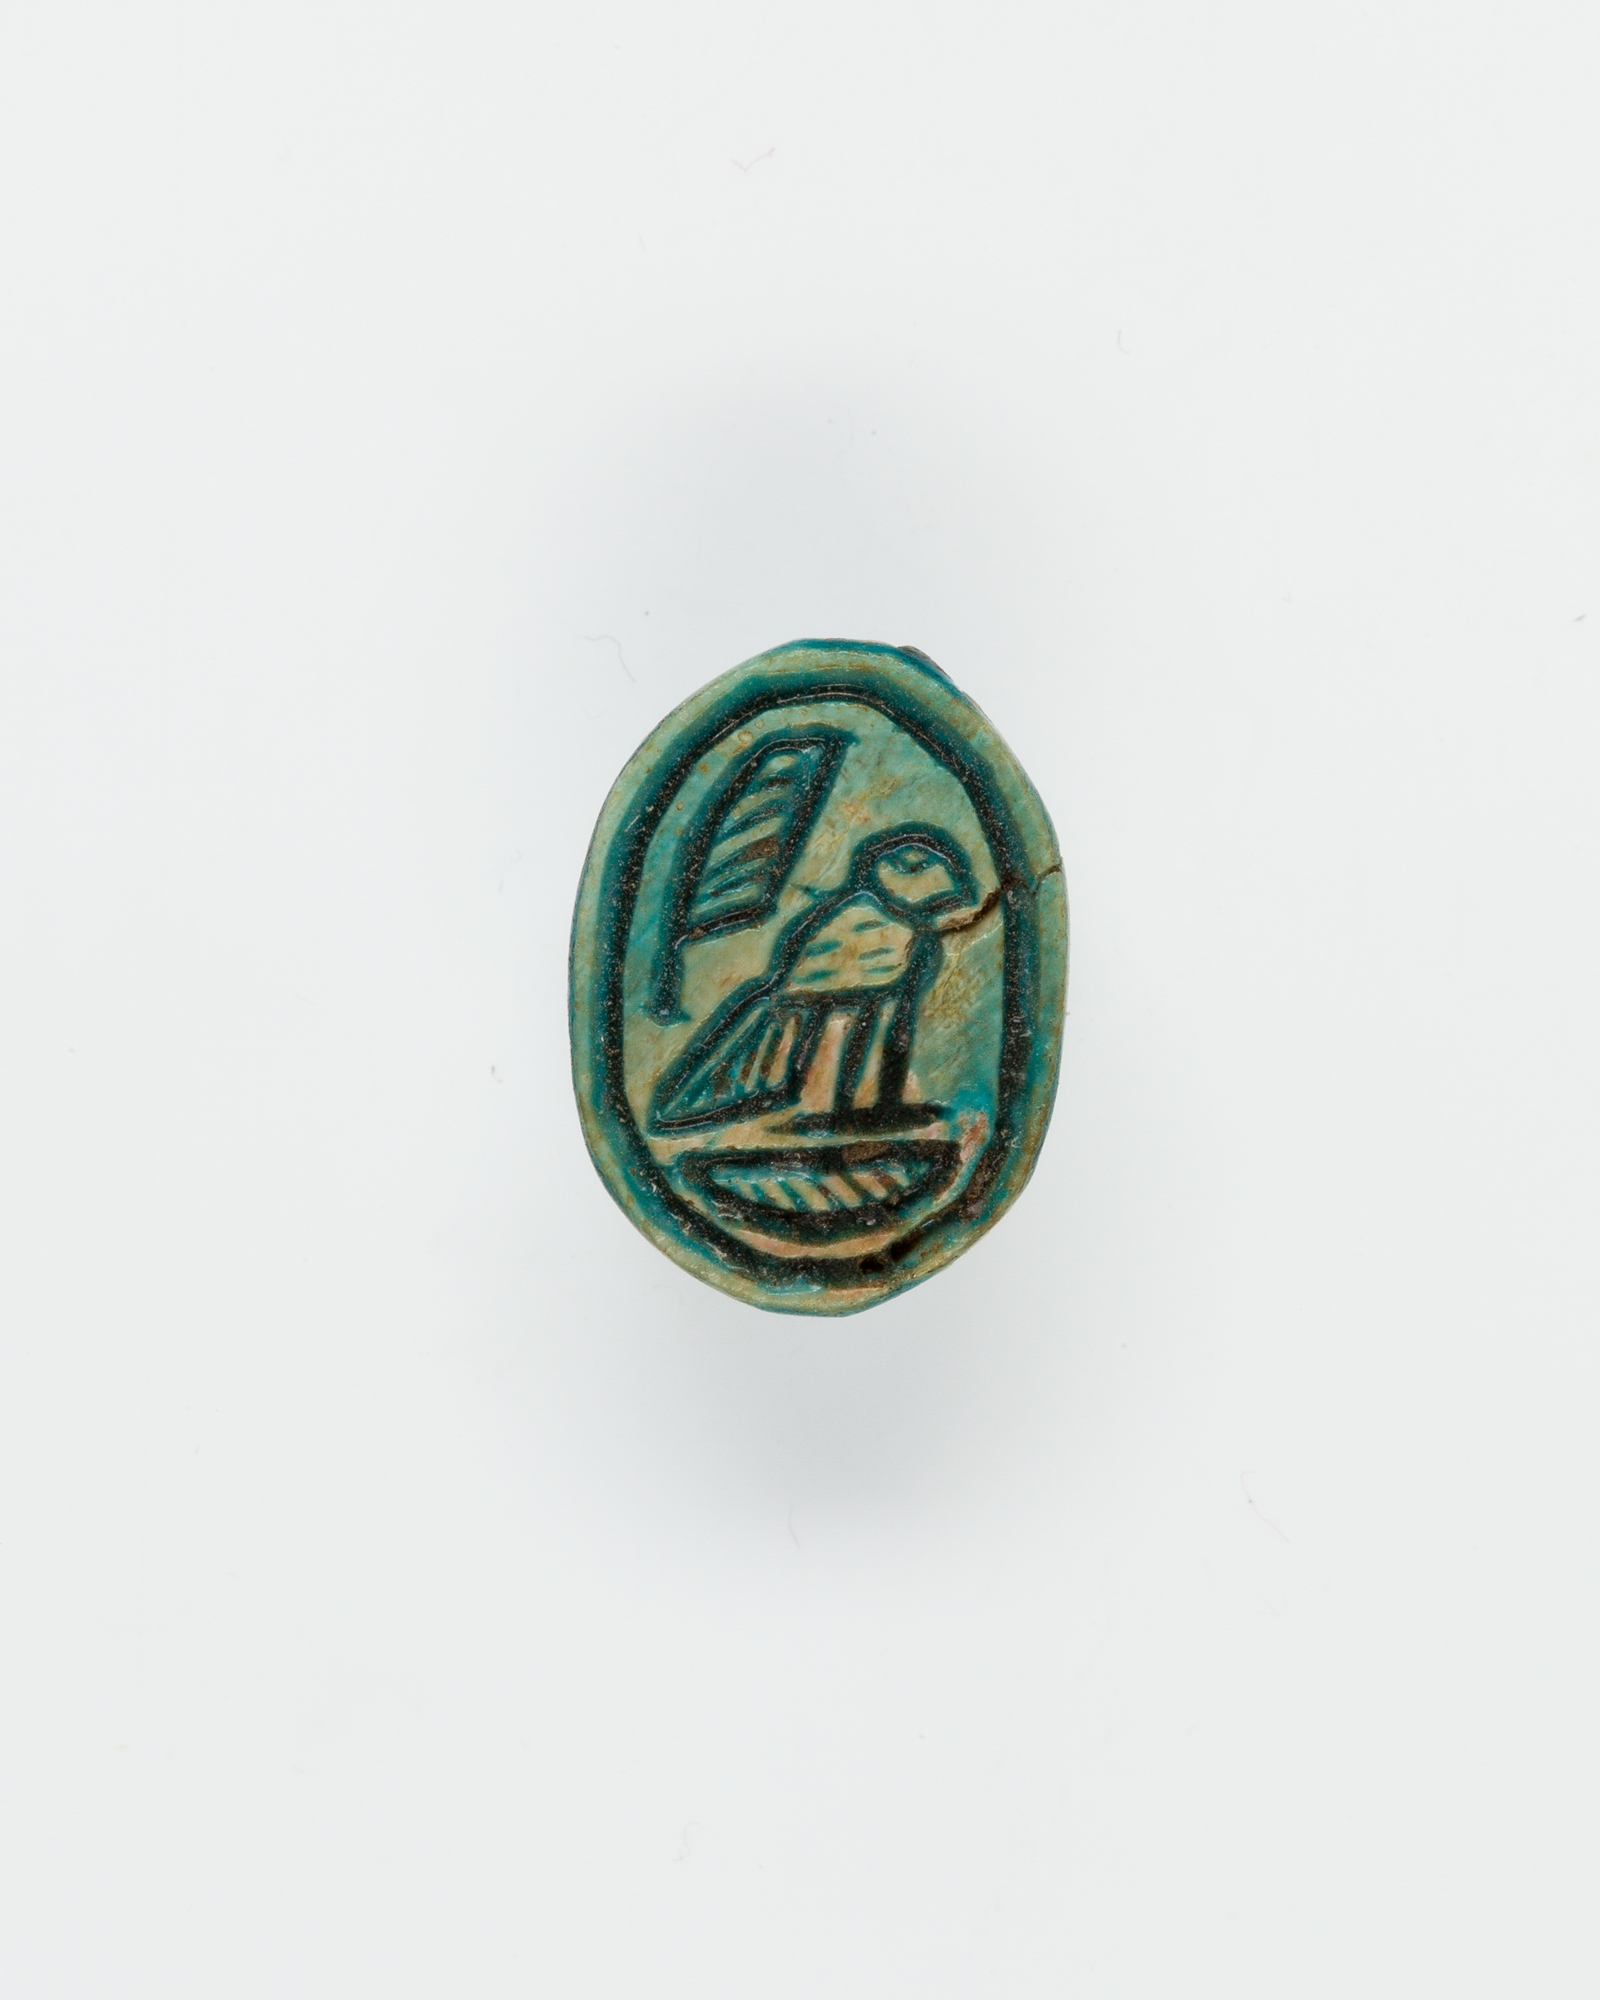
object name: scarab, falcon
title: Scarab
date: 1492-1479 BCE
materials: stone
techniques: glazing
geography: egypt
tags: birds,scarabs